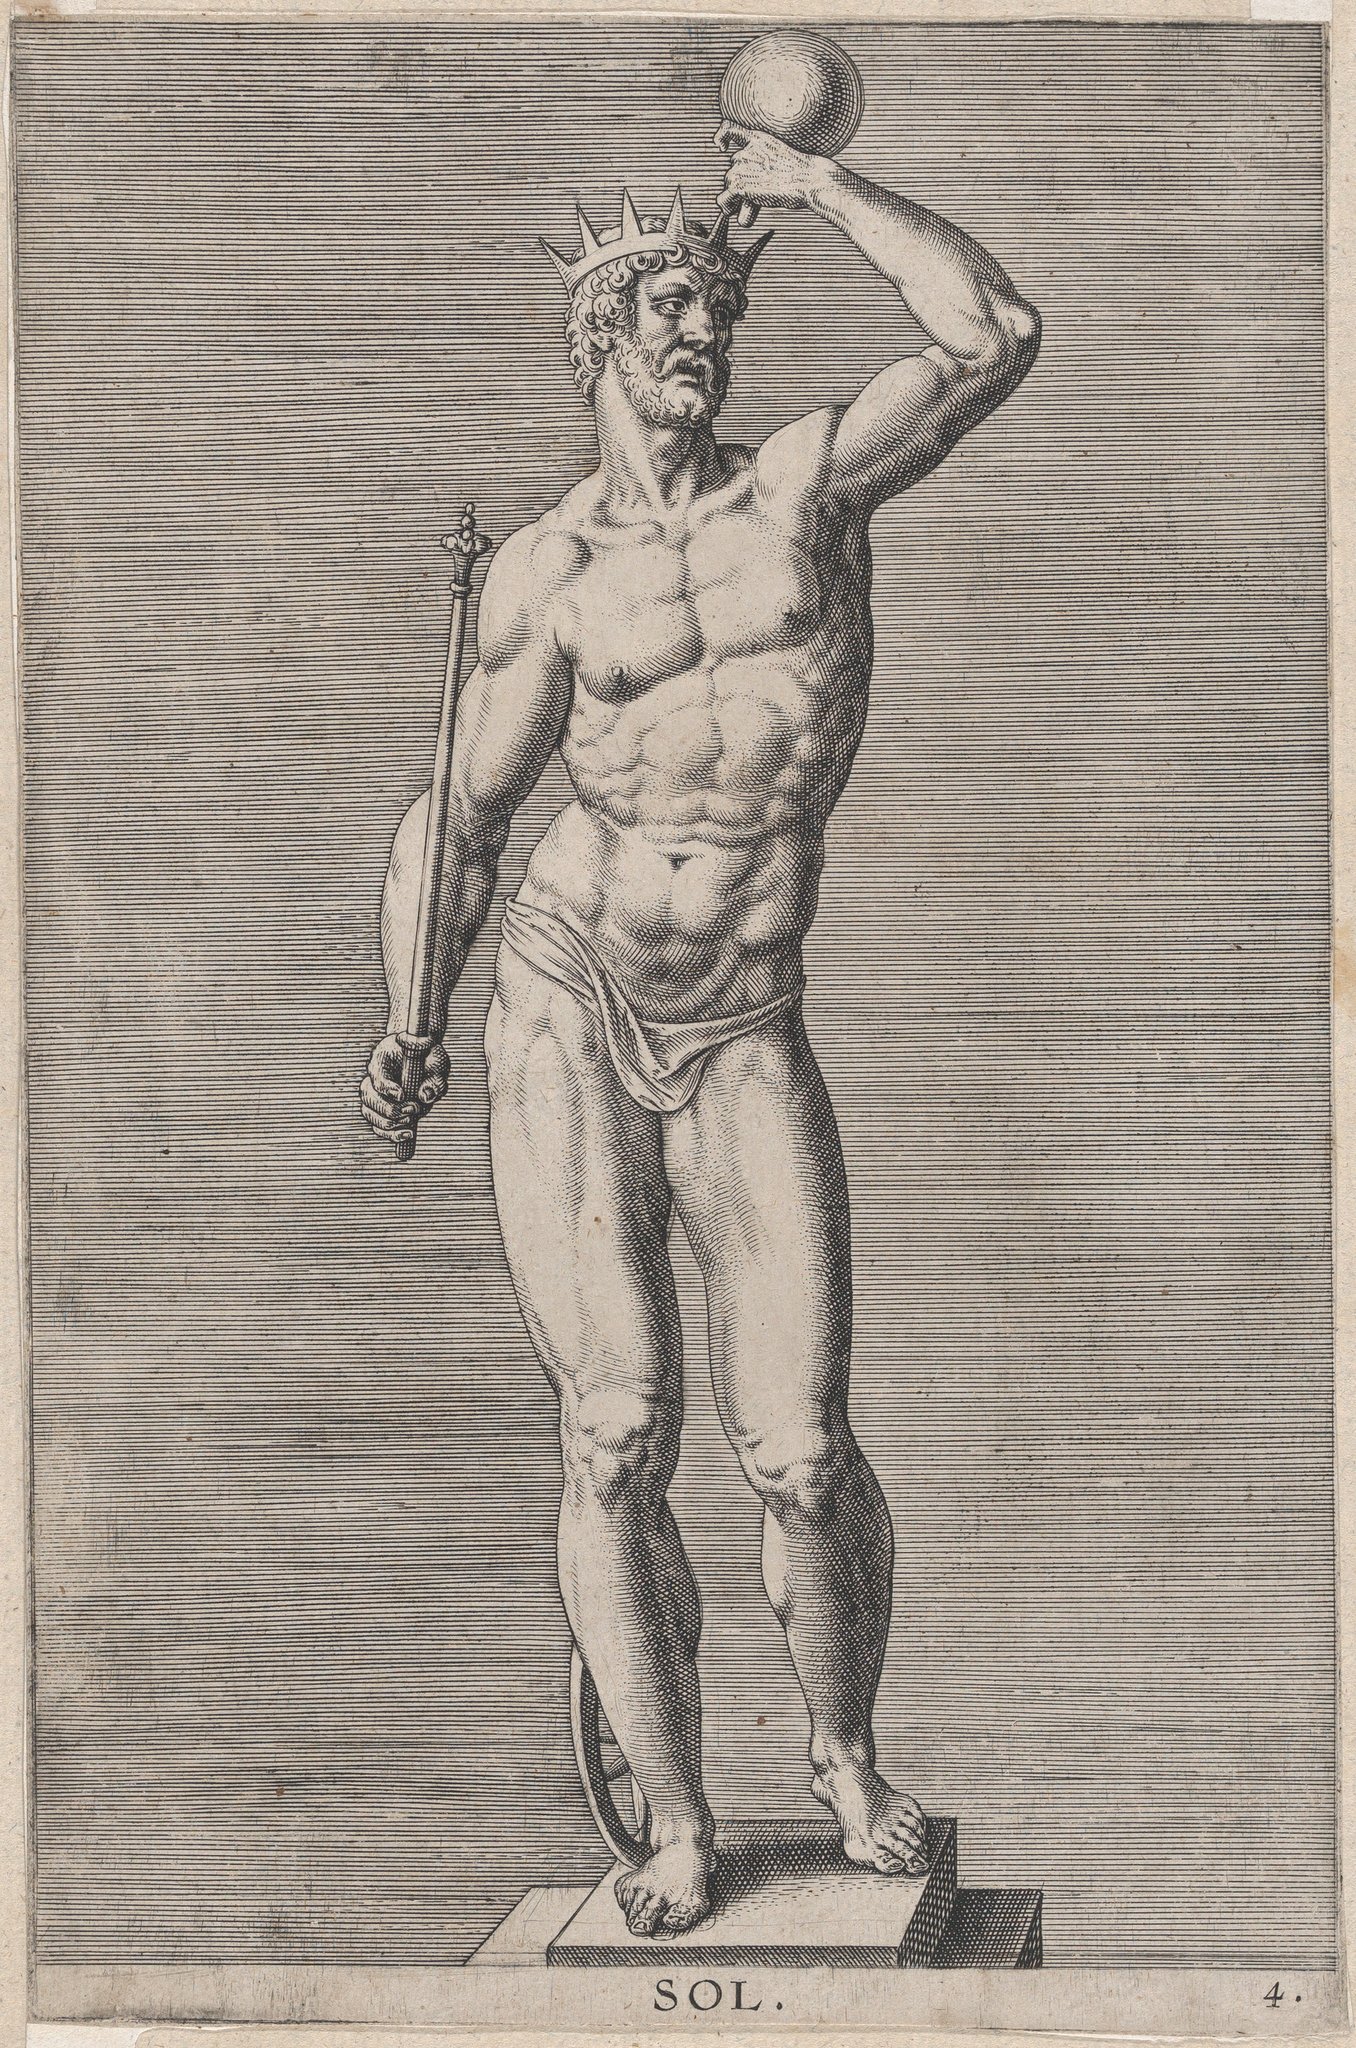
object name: print, fete, ornament architecture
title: Apollo; statue of the nude god standing on a socle, wearing a crown and holding a scepter in his right hand and an orb in his left, plate 4 from "Statues of Roman Gods"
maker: philips galle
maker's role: artist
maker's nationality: netherlandish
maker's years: 1537-1612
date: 1586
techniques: engraving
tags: apollo